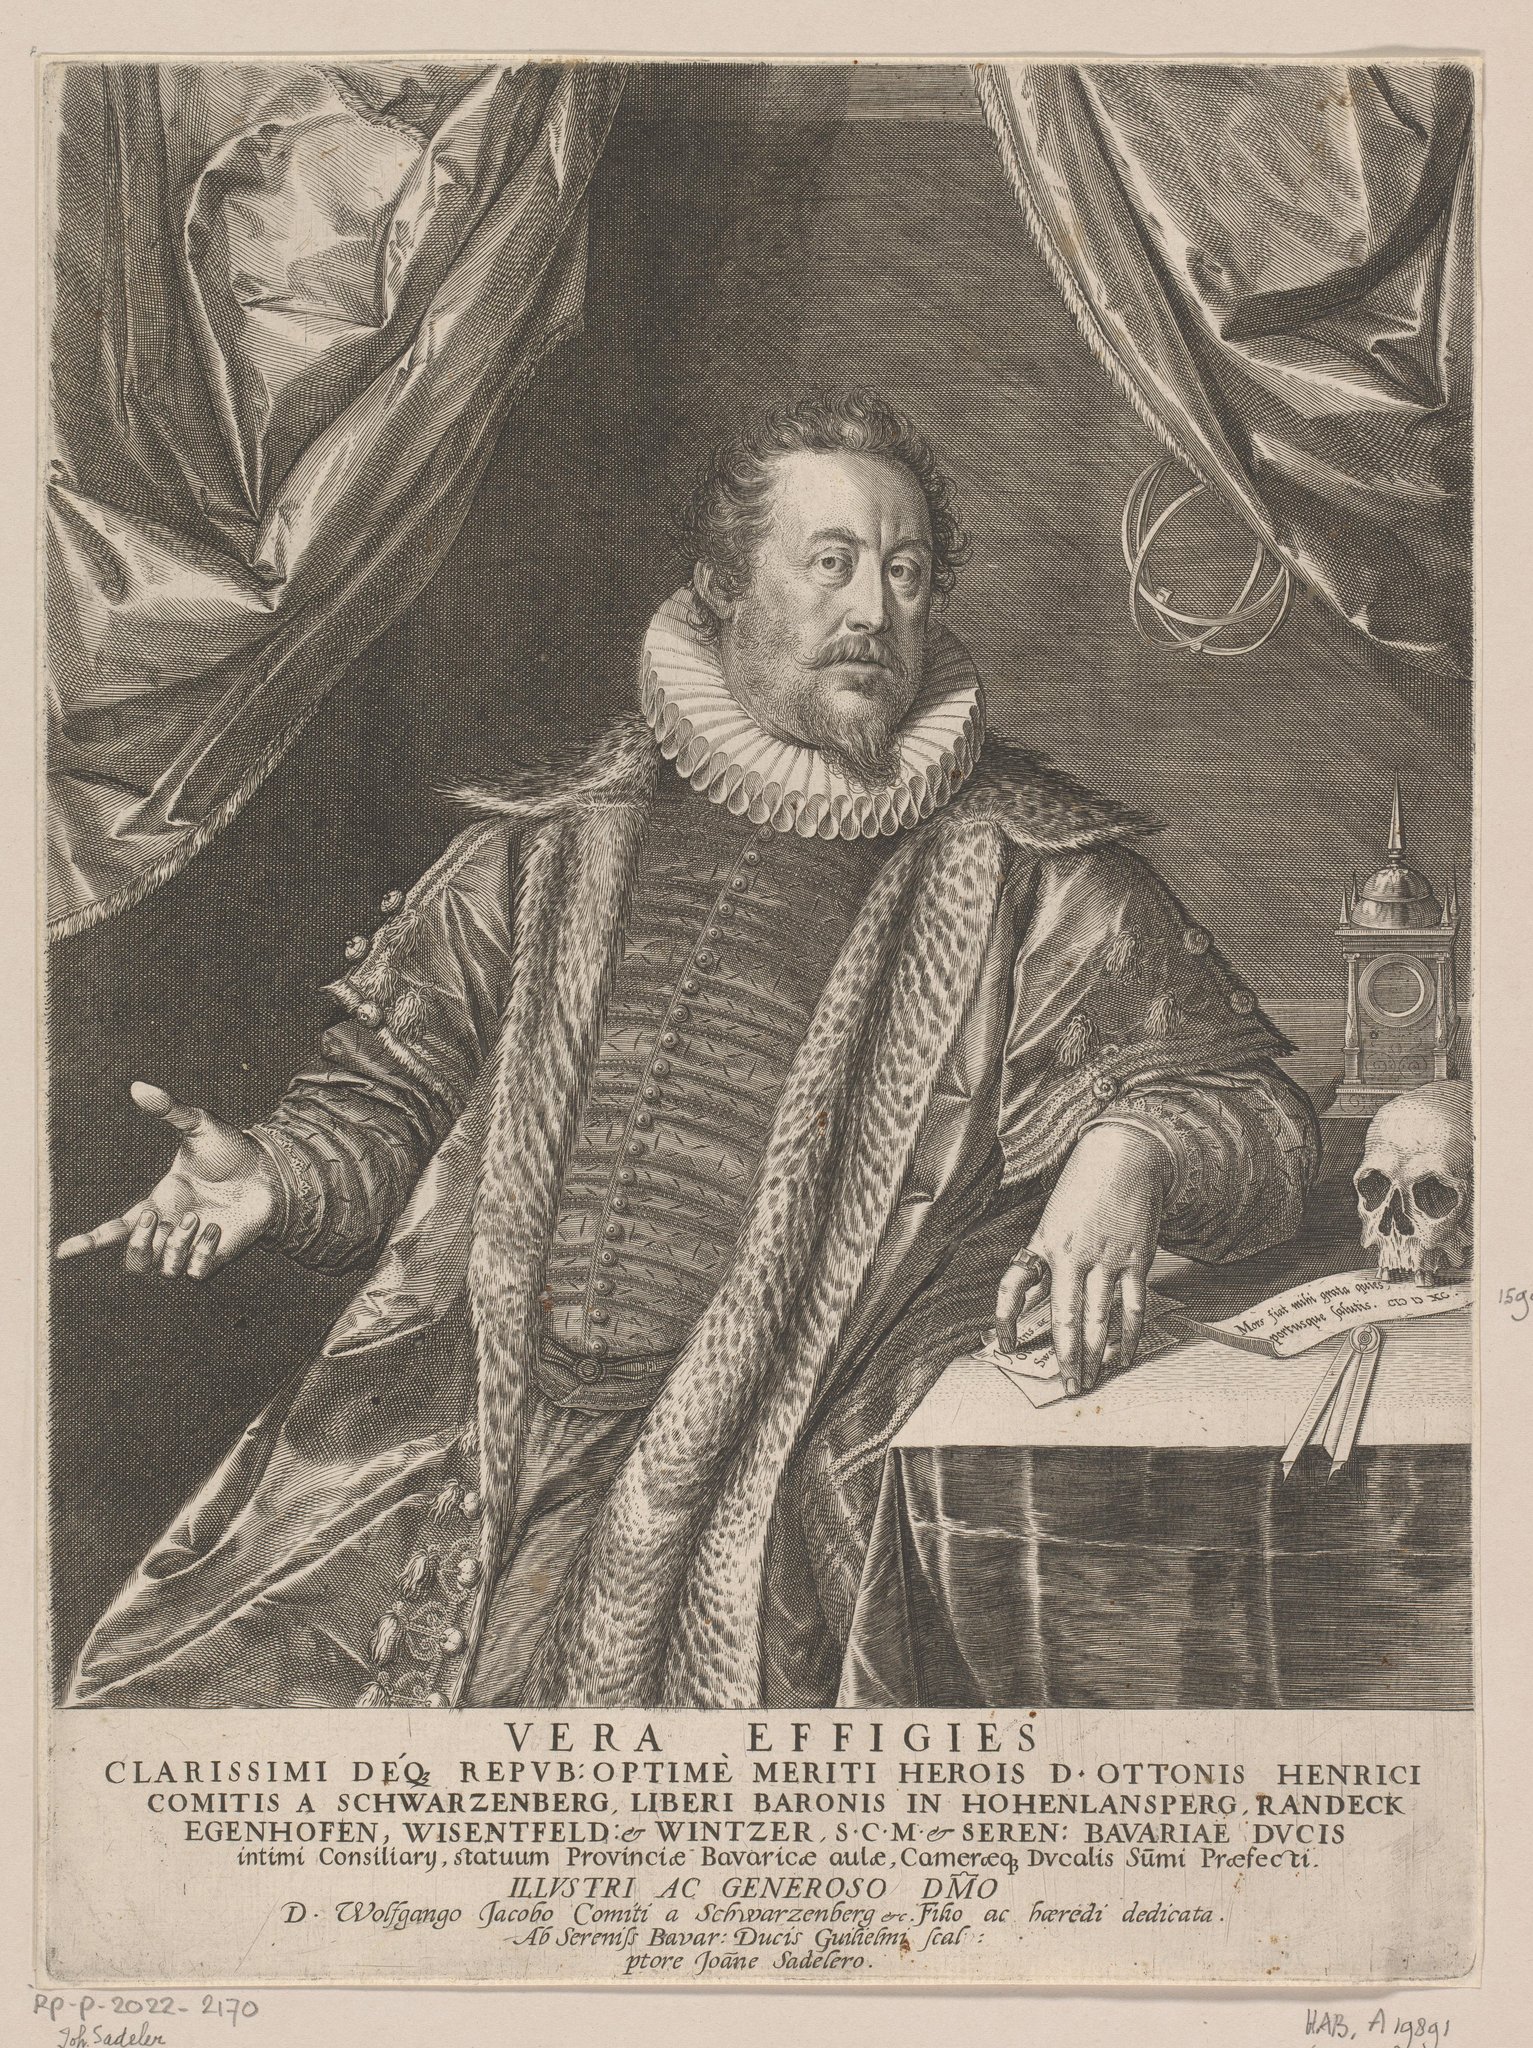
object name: print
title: Portret van Otto Heinrich von Schwarzenberg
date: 1590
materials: paper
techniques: engraving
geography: munich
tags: earl, politician, otto heinrich von schwarzenberg, historical persons, politician, e.g. party leader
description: Met zesregelig onderschrift in het Latijn.